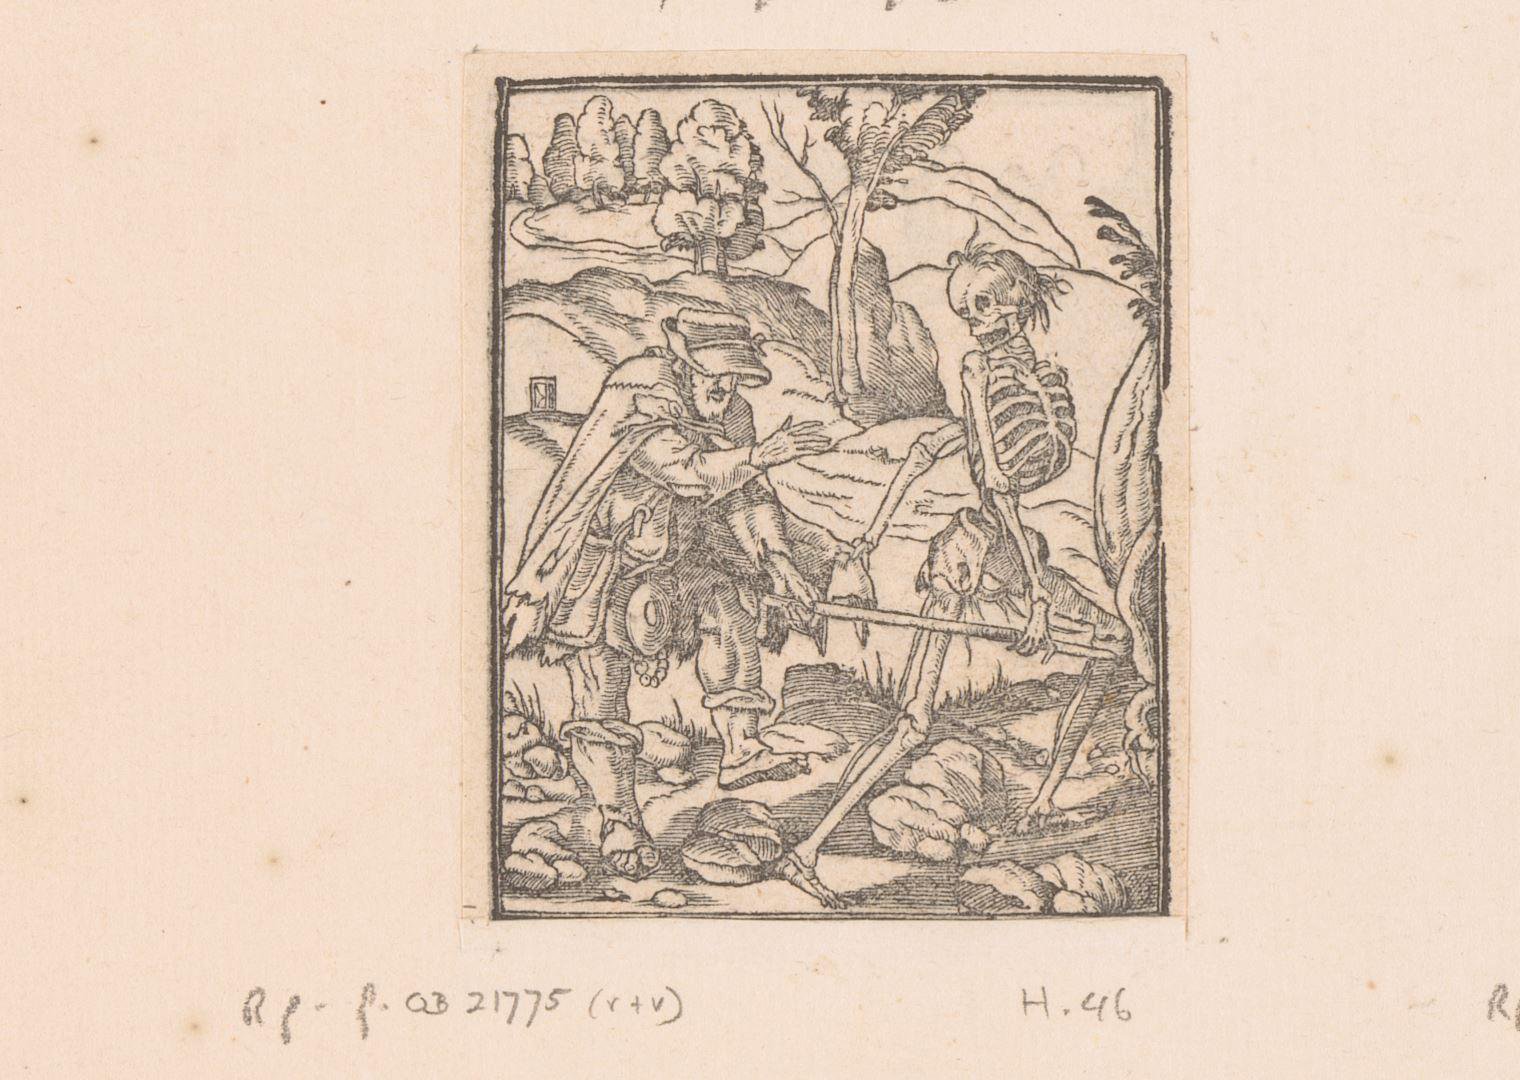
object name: book illustration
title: Kopieën naar Holbeins Dodendans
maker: Anonymous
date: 1547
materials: paper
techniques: woodcut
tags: dance of death; death together with one or more human beings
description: Kopie van een prent van Hans Holbein de jongere uit 1538, voor het eerst gepubliceerd in: Imagines mortis (...). Lyon: Johannes Frellon, 1547.